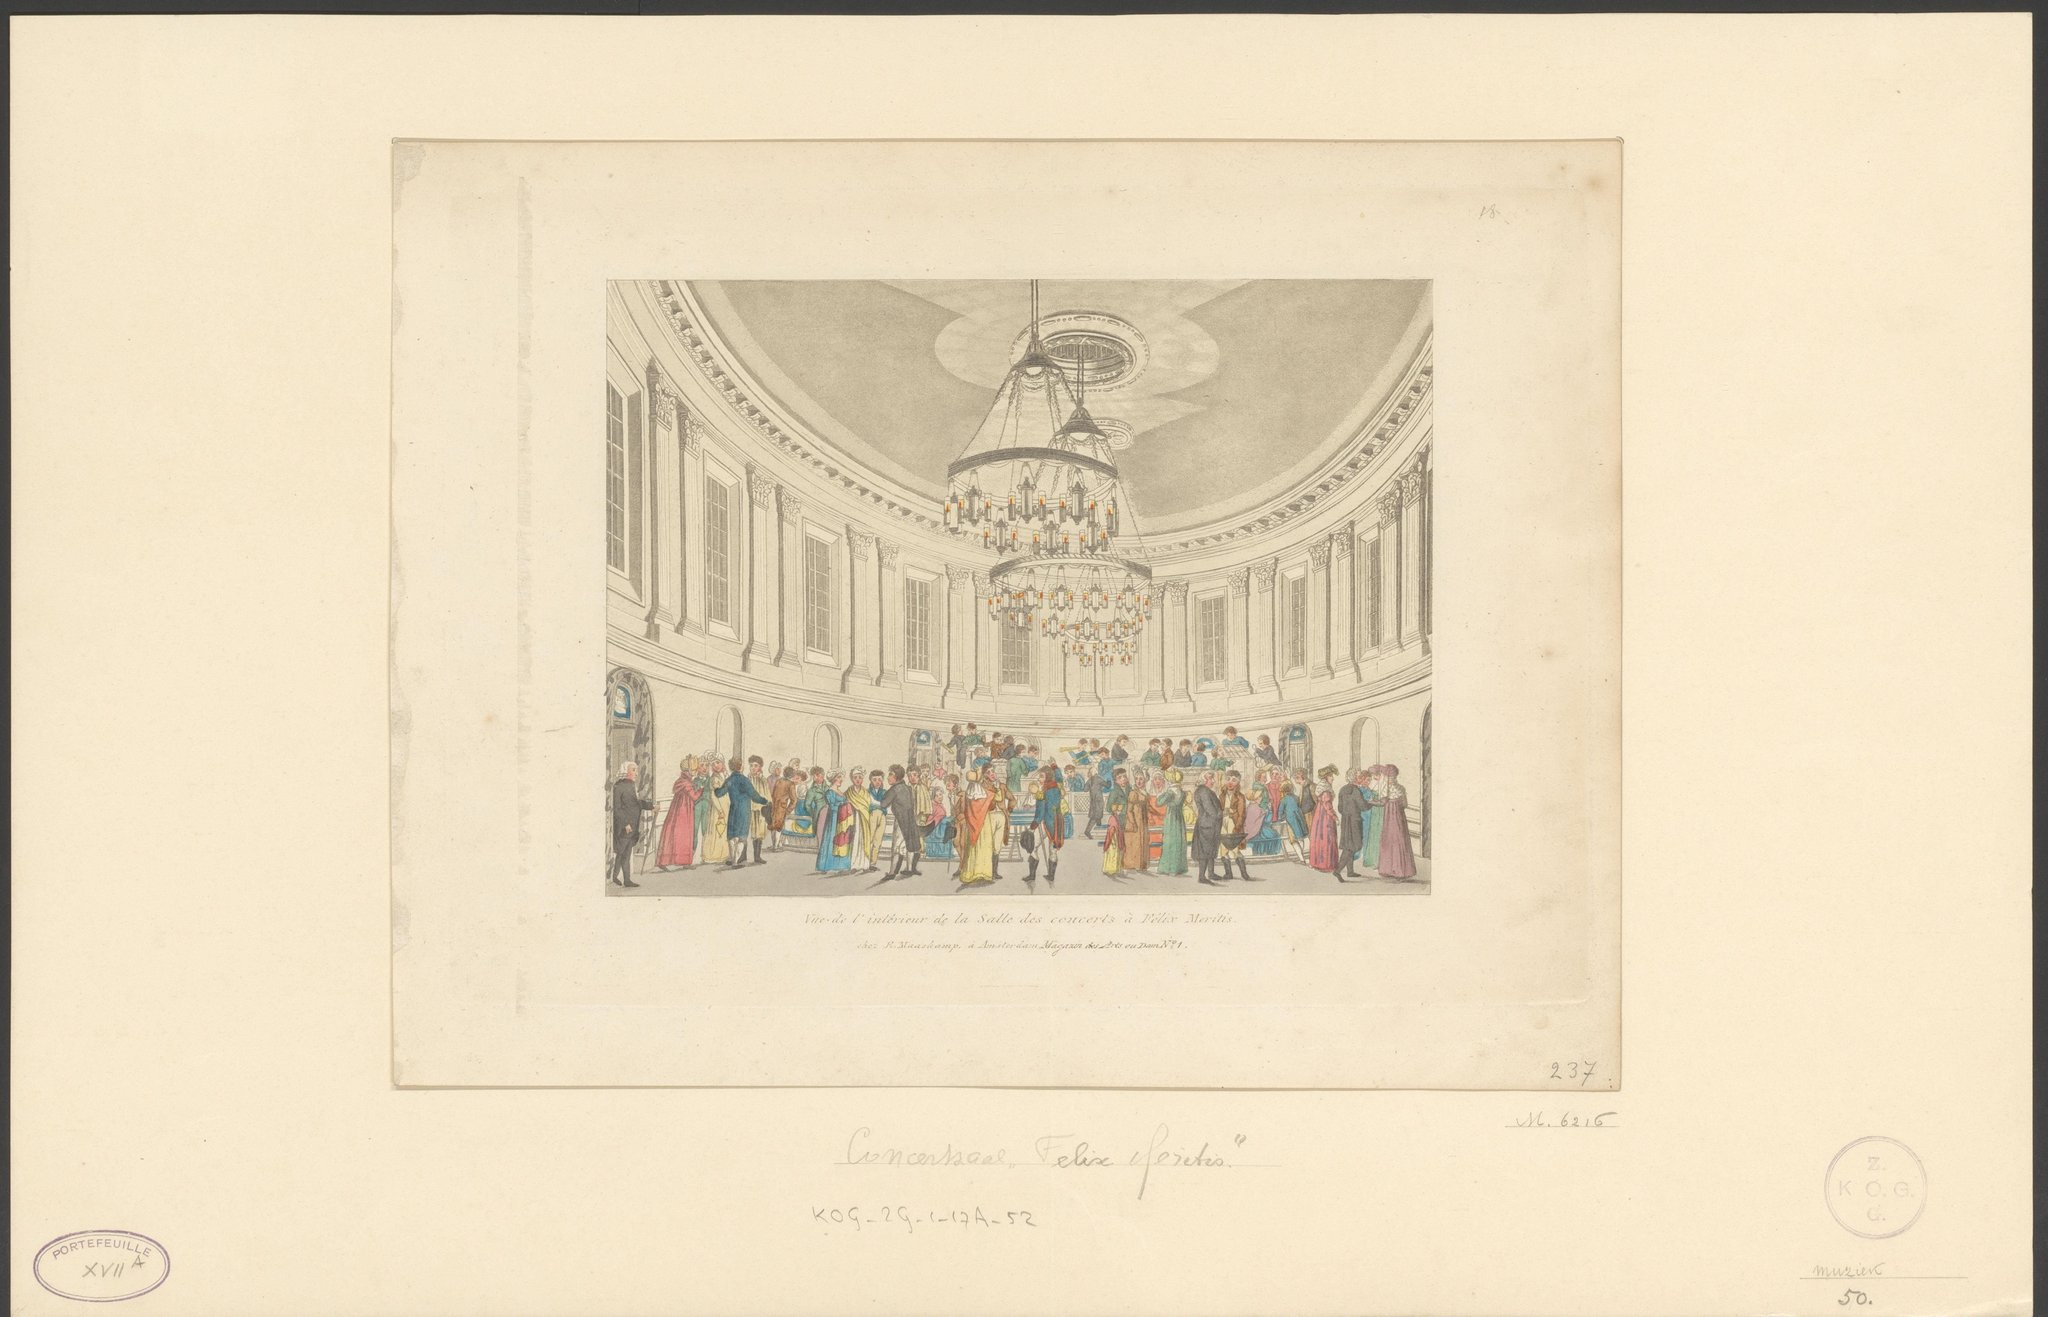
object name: print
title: Concertzaal in Felix Meritis, ca. 1810-1813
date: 1810-1813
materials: paper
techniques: aquatint, etching, hand coloring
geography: amsterdam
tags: large group of musicians, orchestra, concert hall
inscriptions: collector's mark, collector's mark: Lugt 1641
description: Bezoekers in de Concertzaal in het gebouw van de maatschappij Felix Meritis te Amsterdam, ingewijd in 1789. Groepjes mensen zijn met elkaar in gesprek, terwijl op het podium het orkest zich voorbereidt. Onderwerpsrubrieken binnen de Atlas Zeden en Gewoonten: Muziek en muziekinstrumenten: Concertzalen.